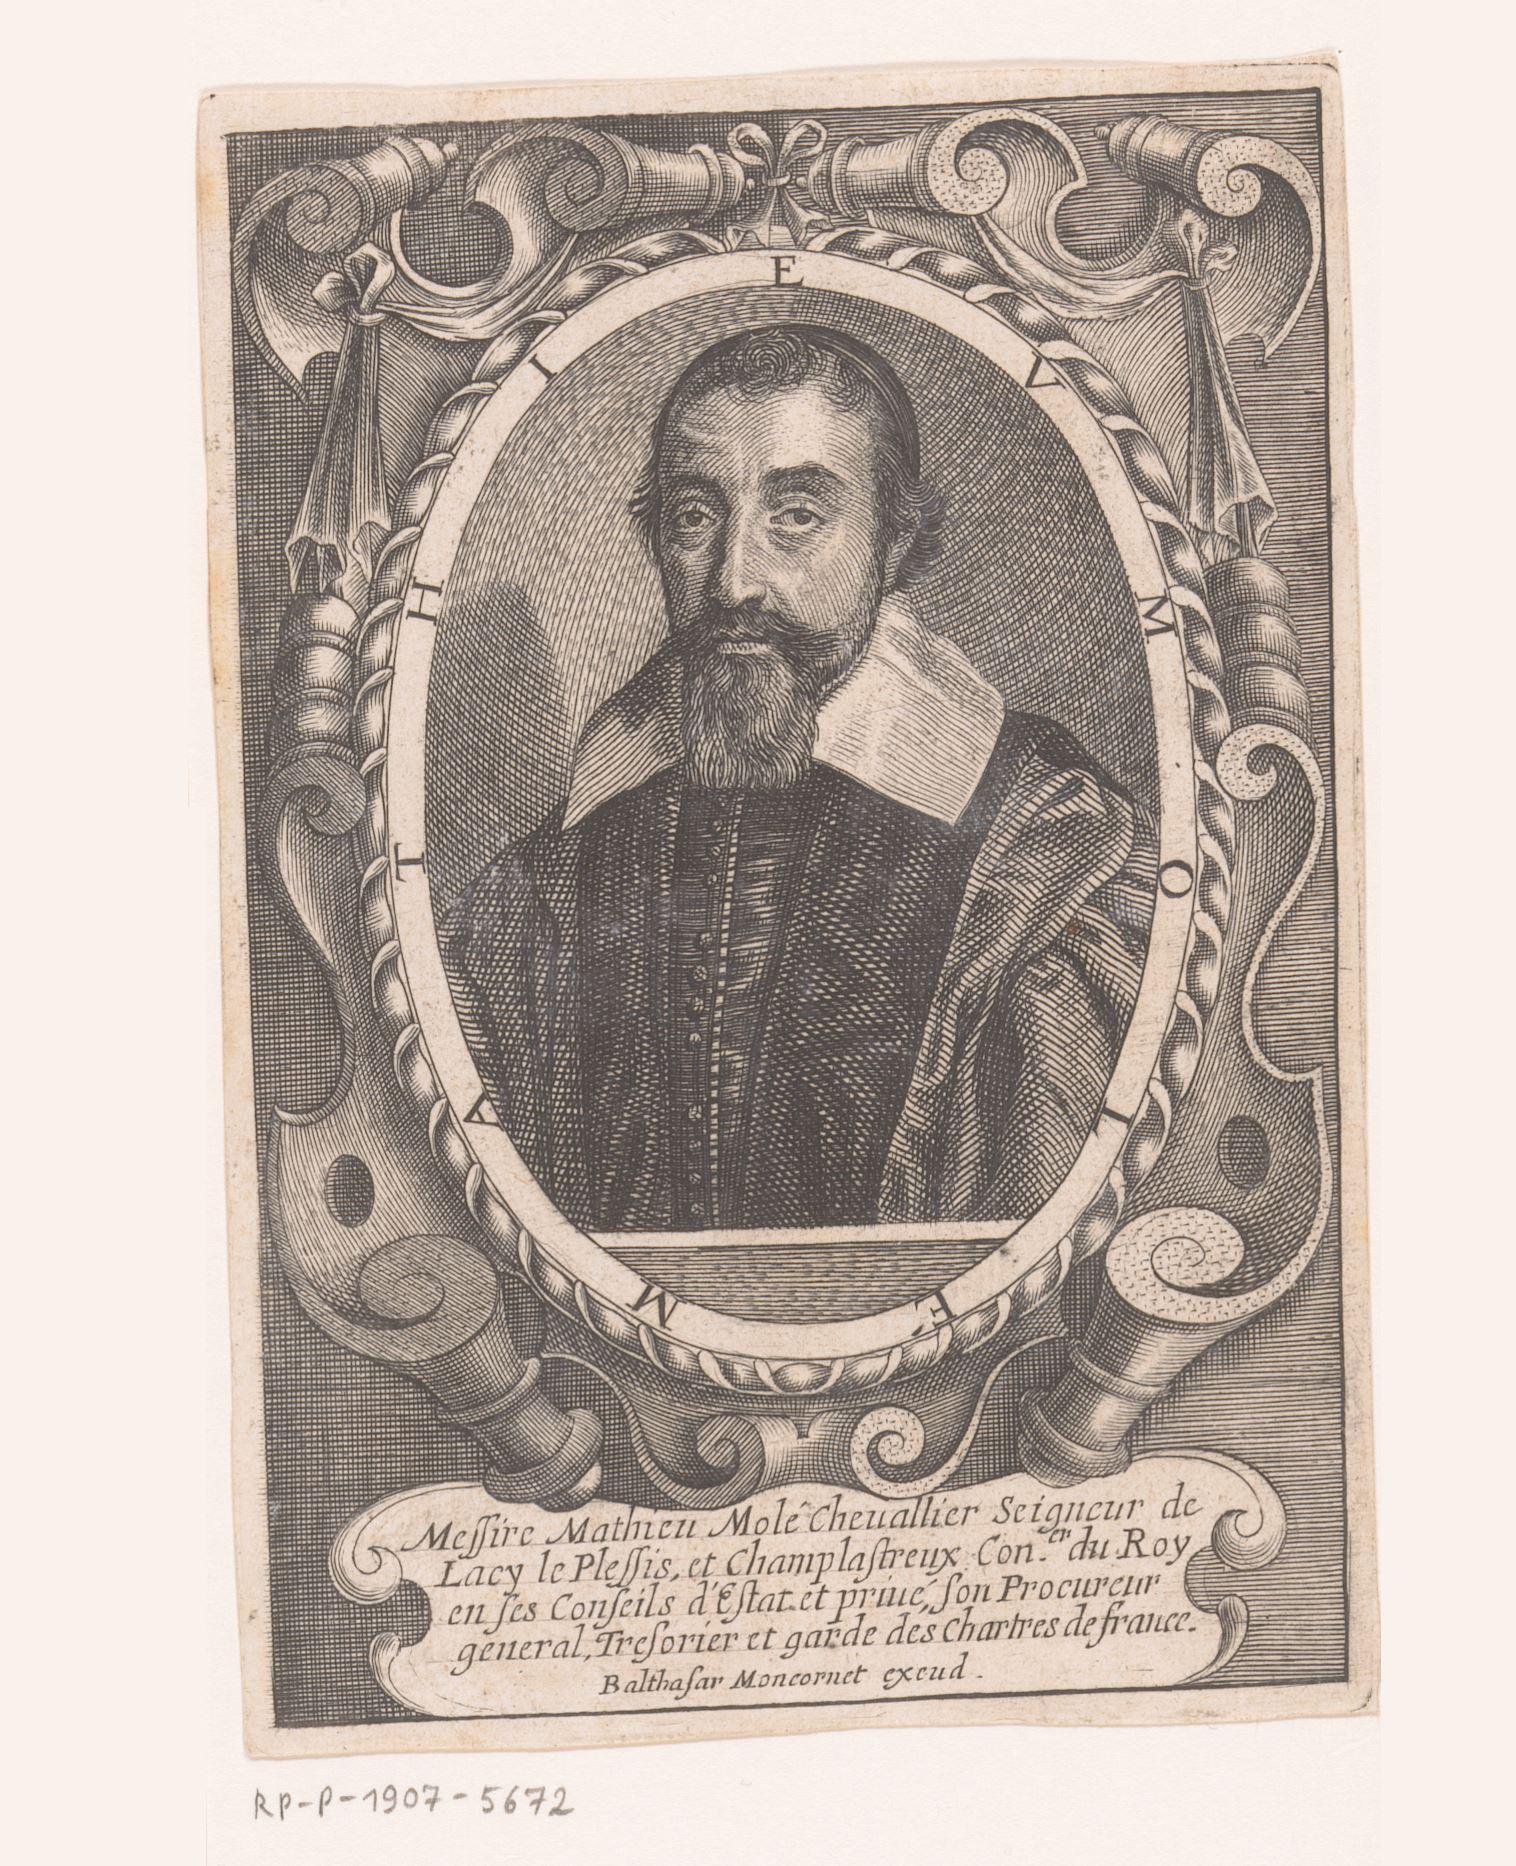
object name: print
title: Portret van Mathieu Molé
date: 1645-1668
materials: paper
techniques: engraving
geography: paris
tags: paris, mathieu molé, official; civil servant; functionary (in general), historical persons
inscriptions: collector's mark: Lugt 2228